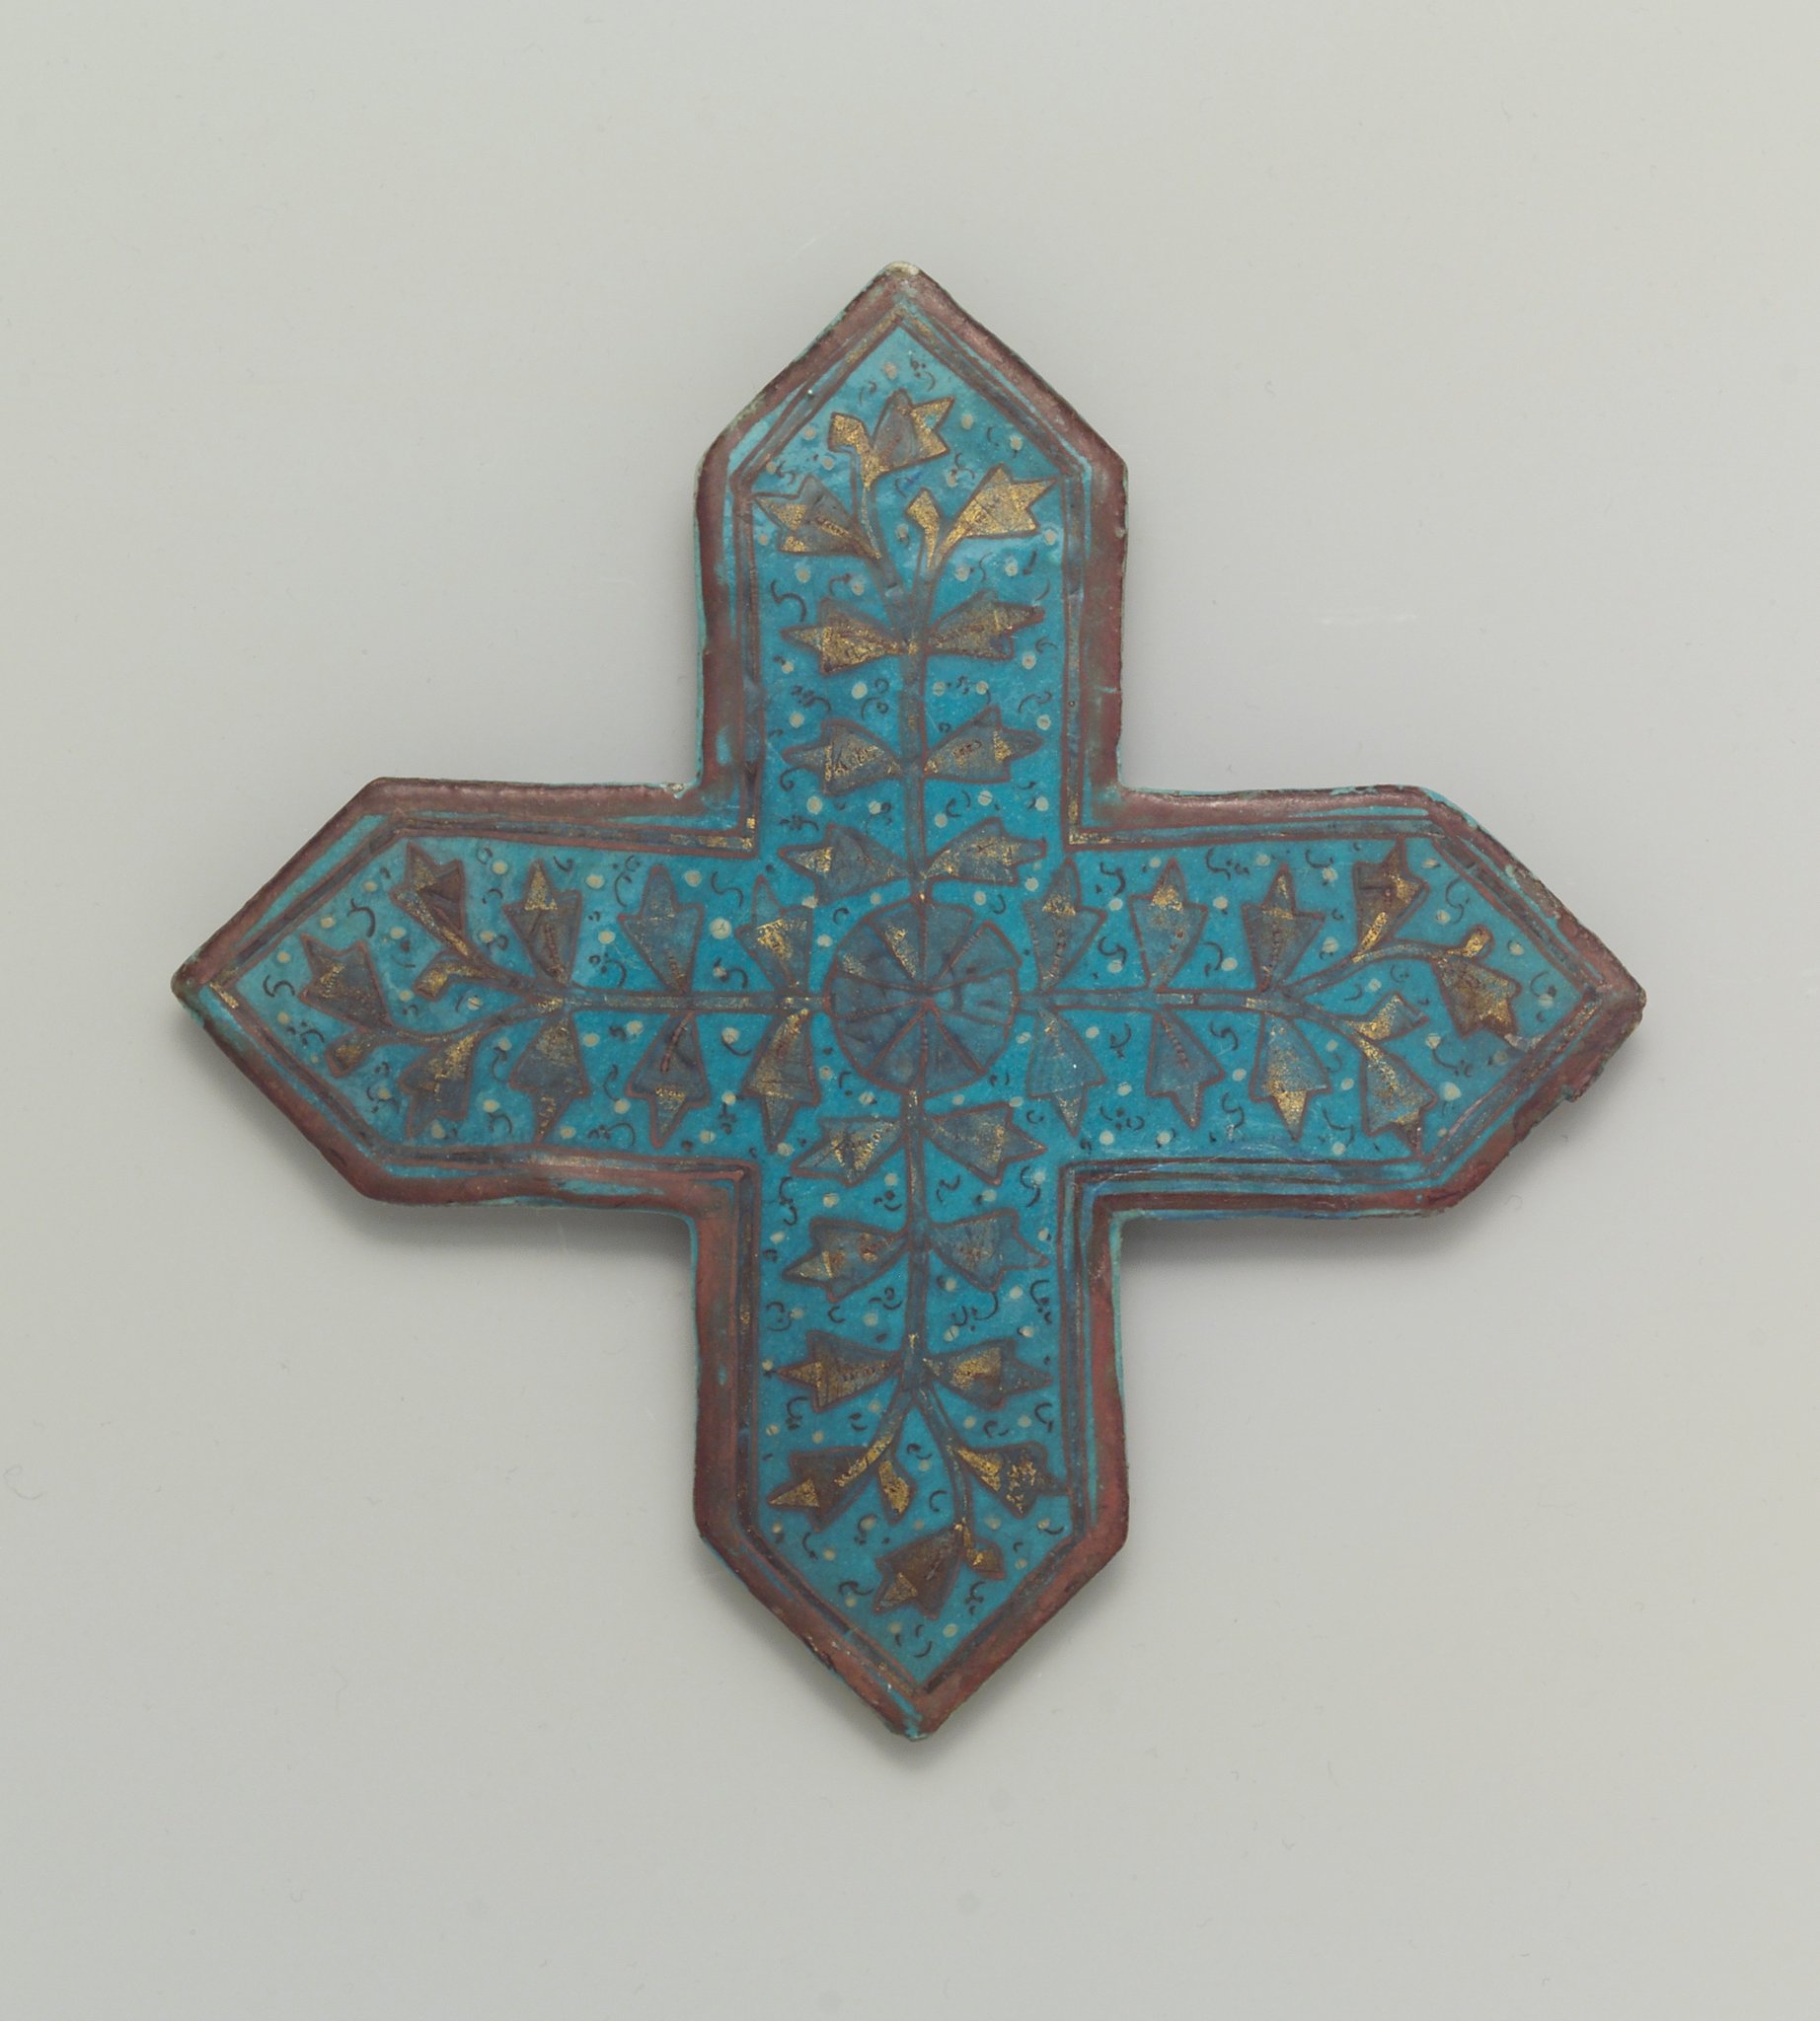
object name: tile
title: Cross-Shaped Tile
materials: stonepaste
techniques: gilding, overglaze, painting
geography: iran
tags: cross